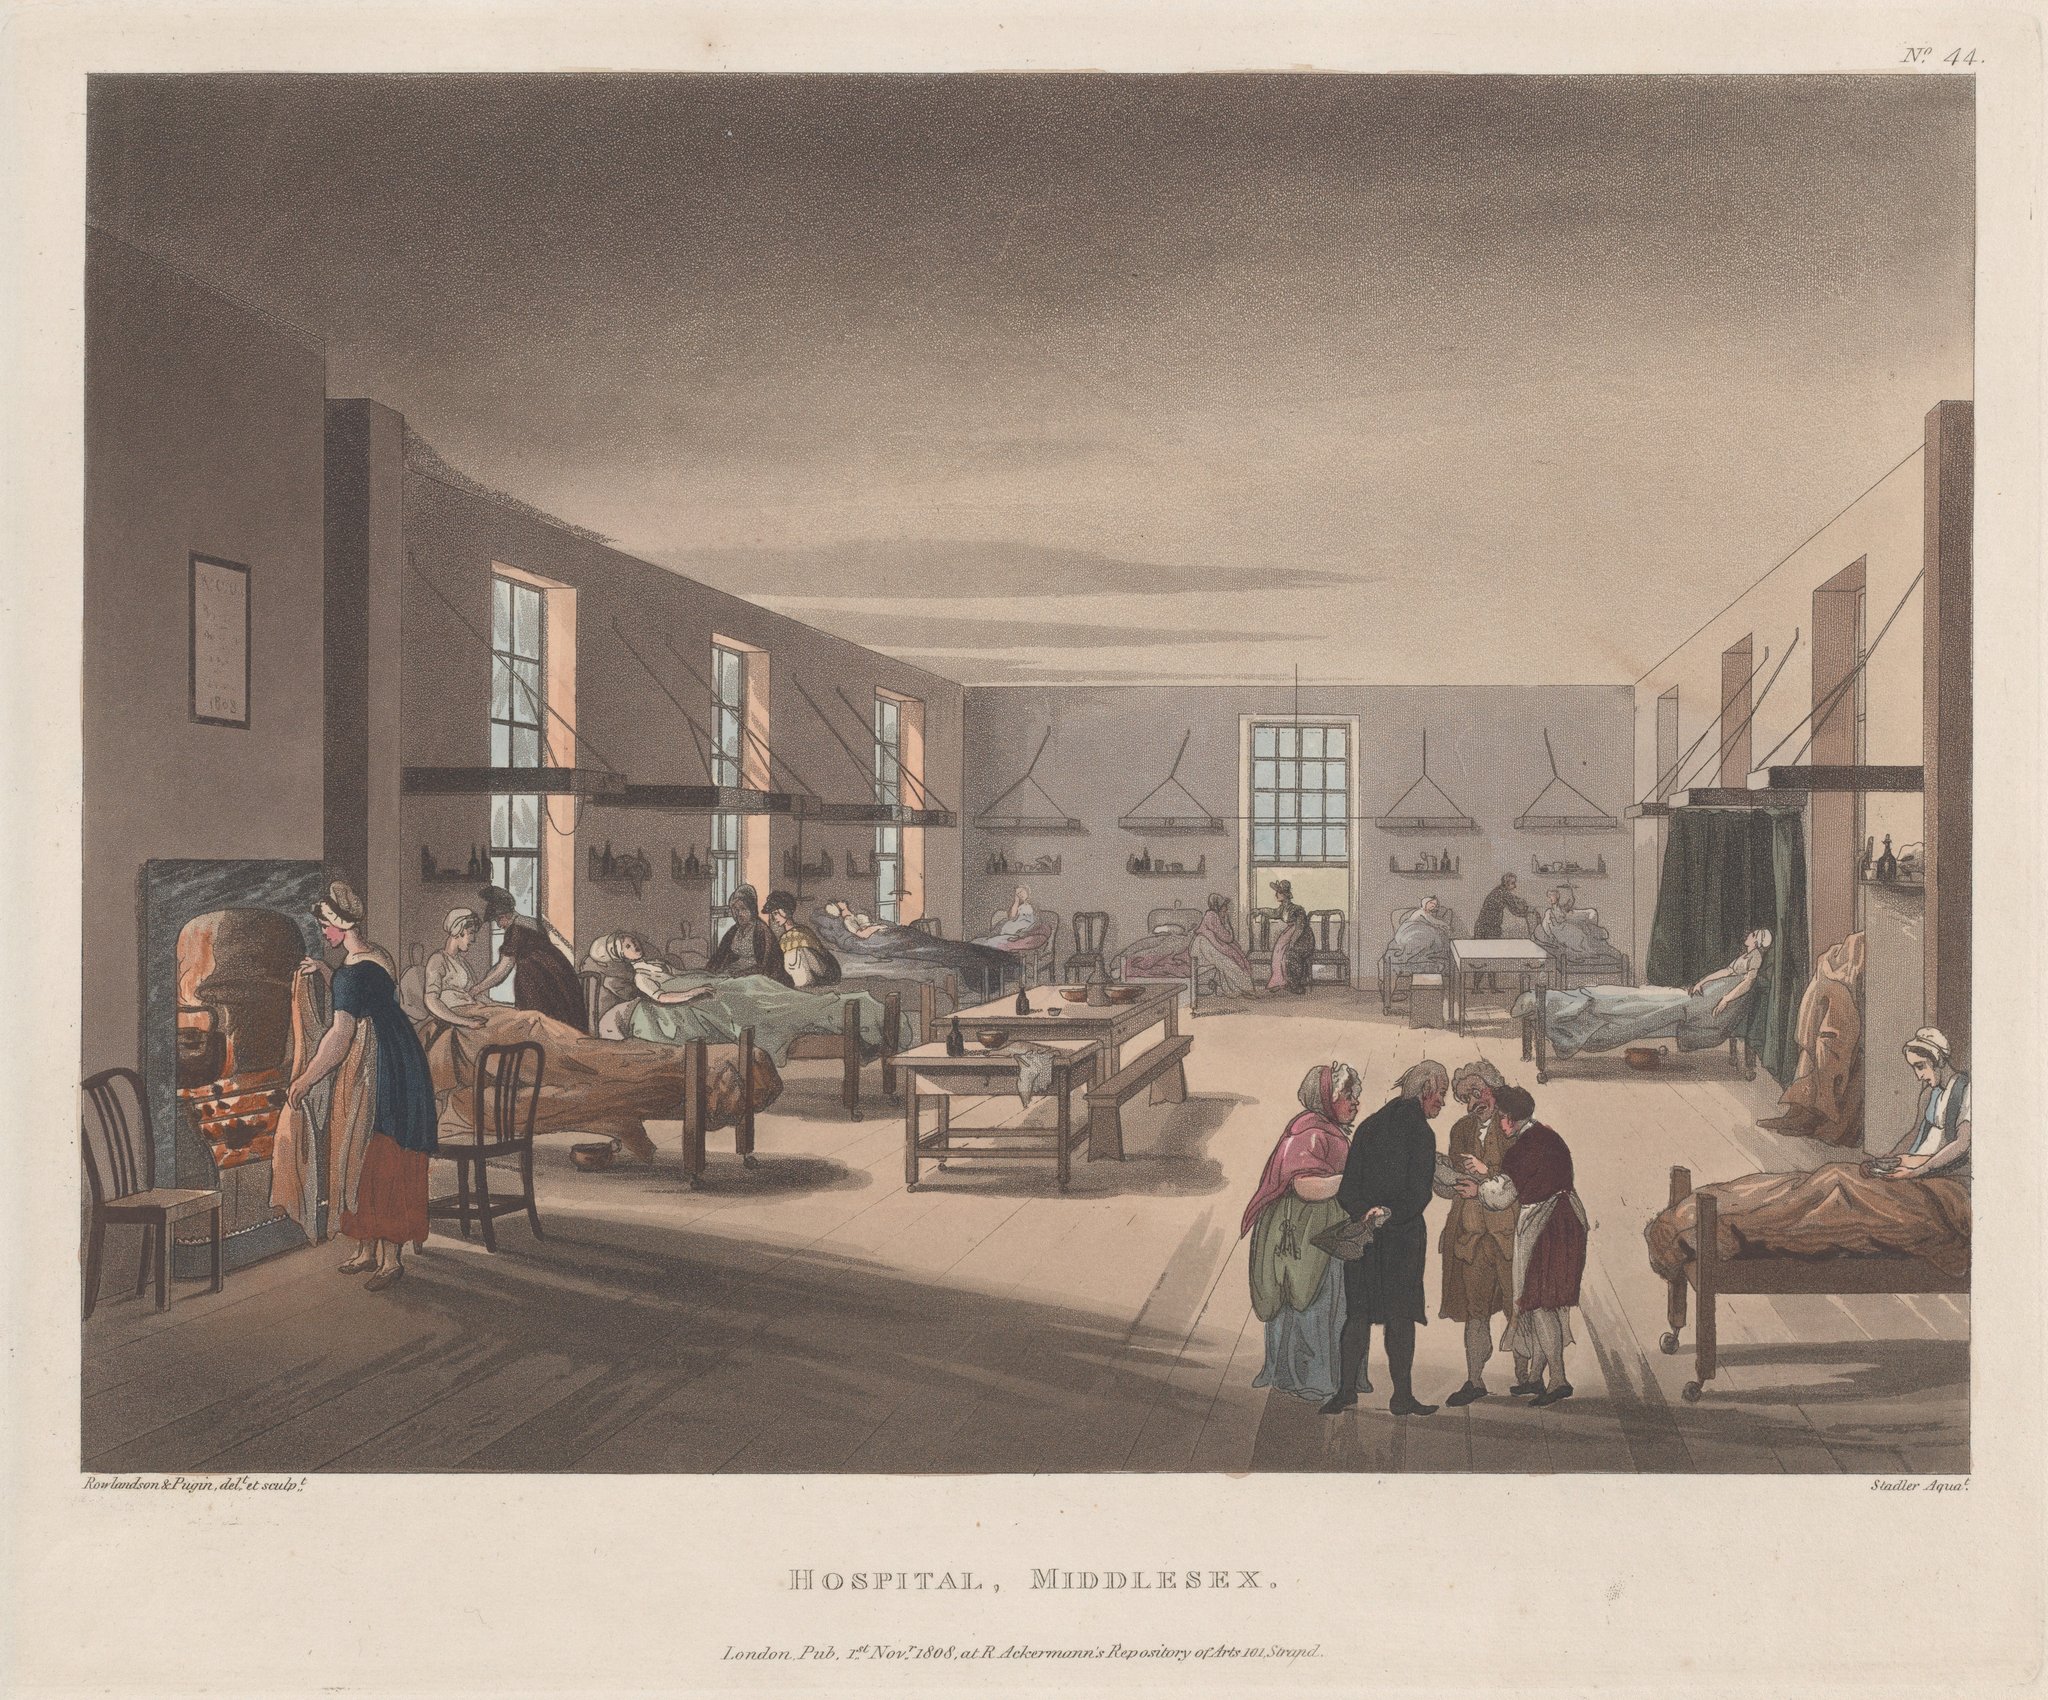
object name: print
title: Hospital, Middlesex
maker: thomas rowlandson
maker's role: artist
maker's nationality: british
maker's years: 1757-1827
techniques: aquatint, etching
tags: hospitals,interiors,illness,men,women